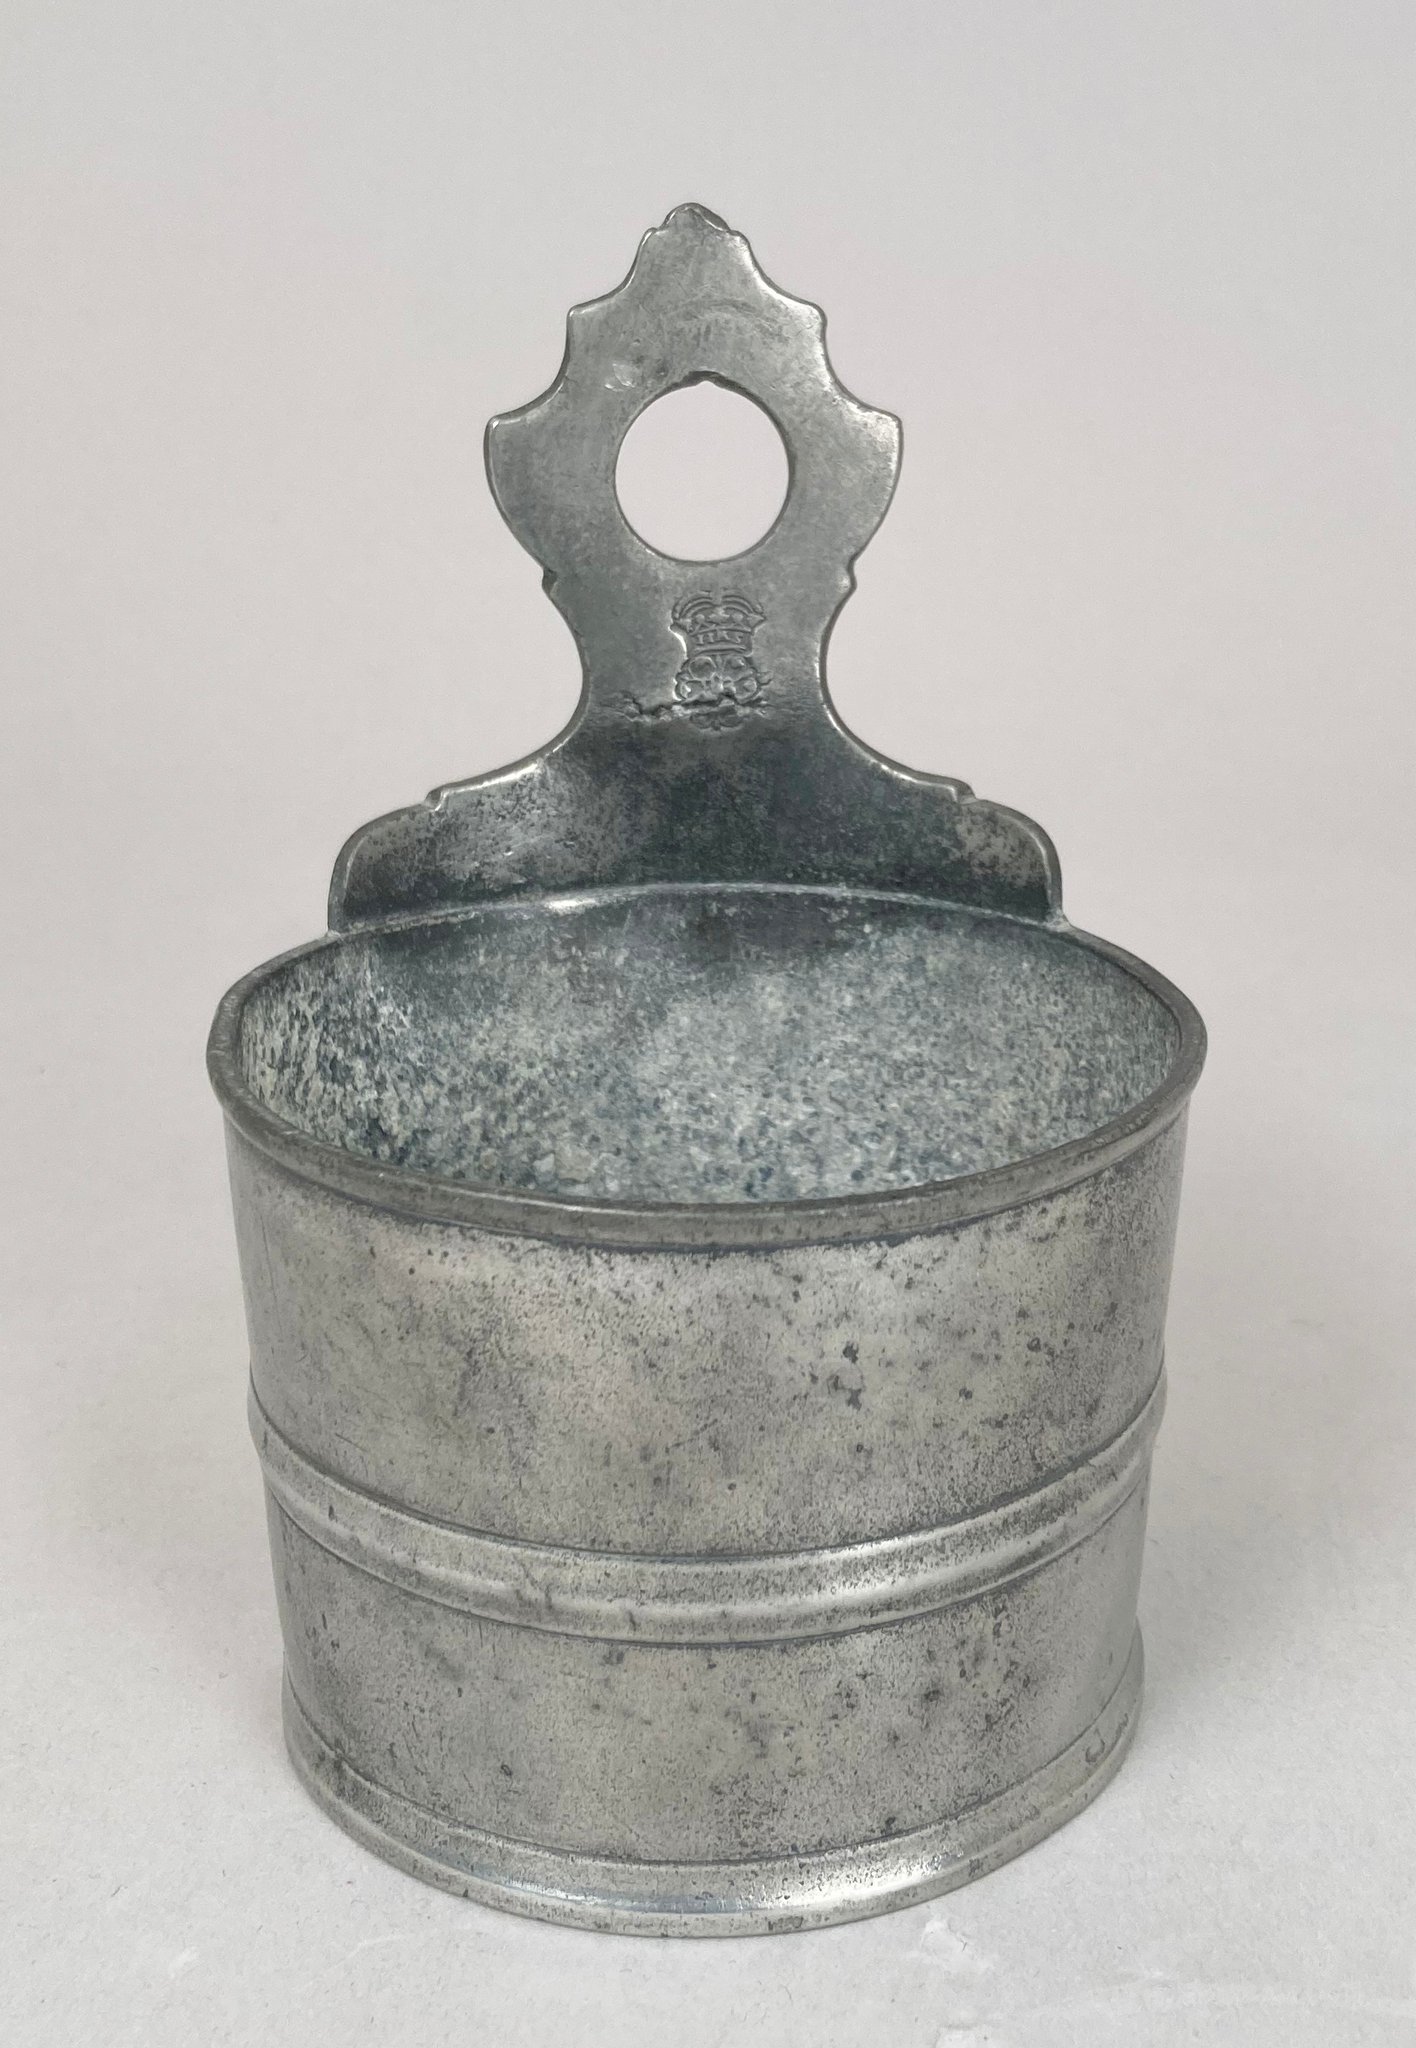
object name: salt box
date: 1701-1800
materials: pewter